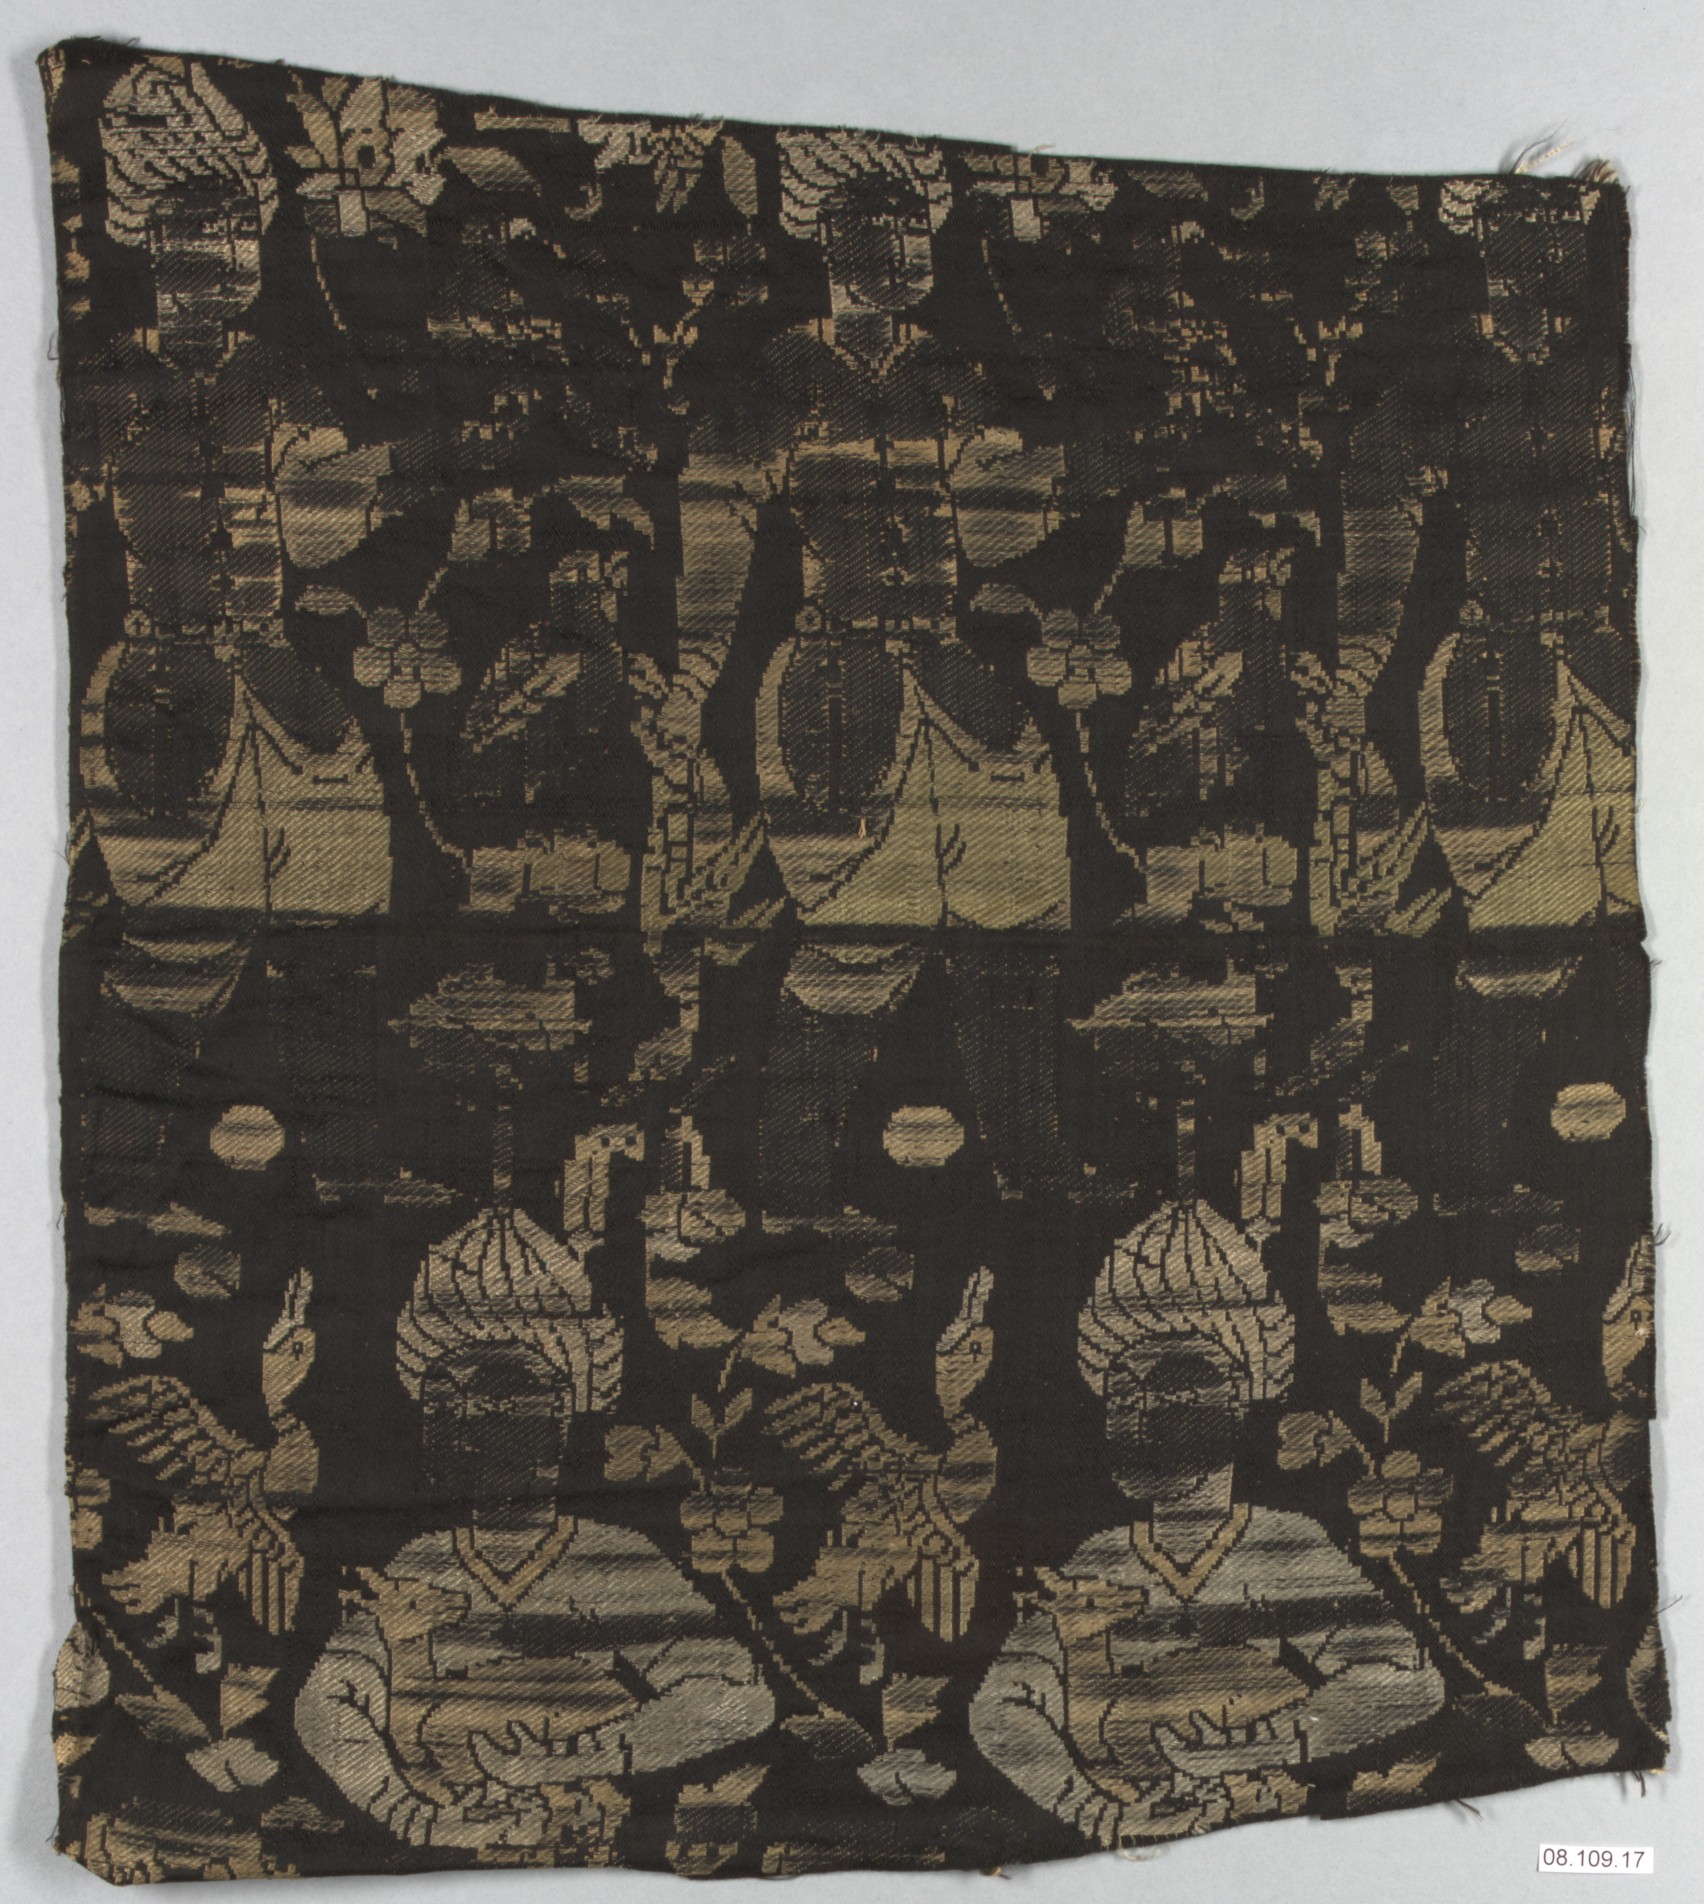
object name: textile fragment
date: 1501-1550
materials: silk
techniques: lampas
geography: iran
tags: ducks,men